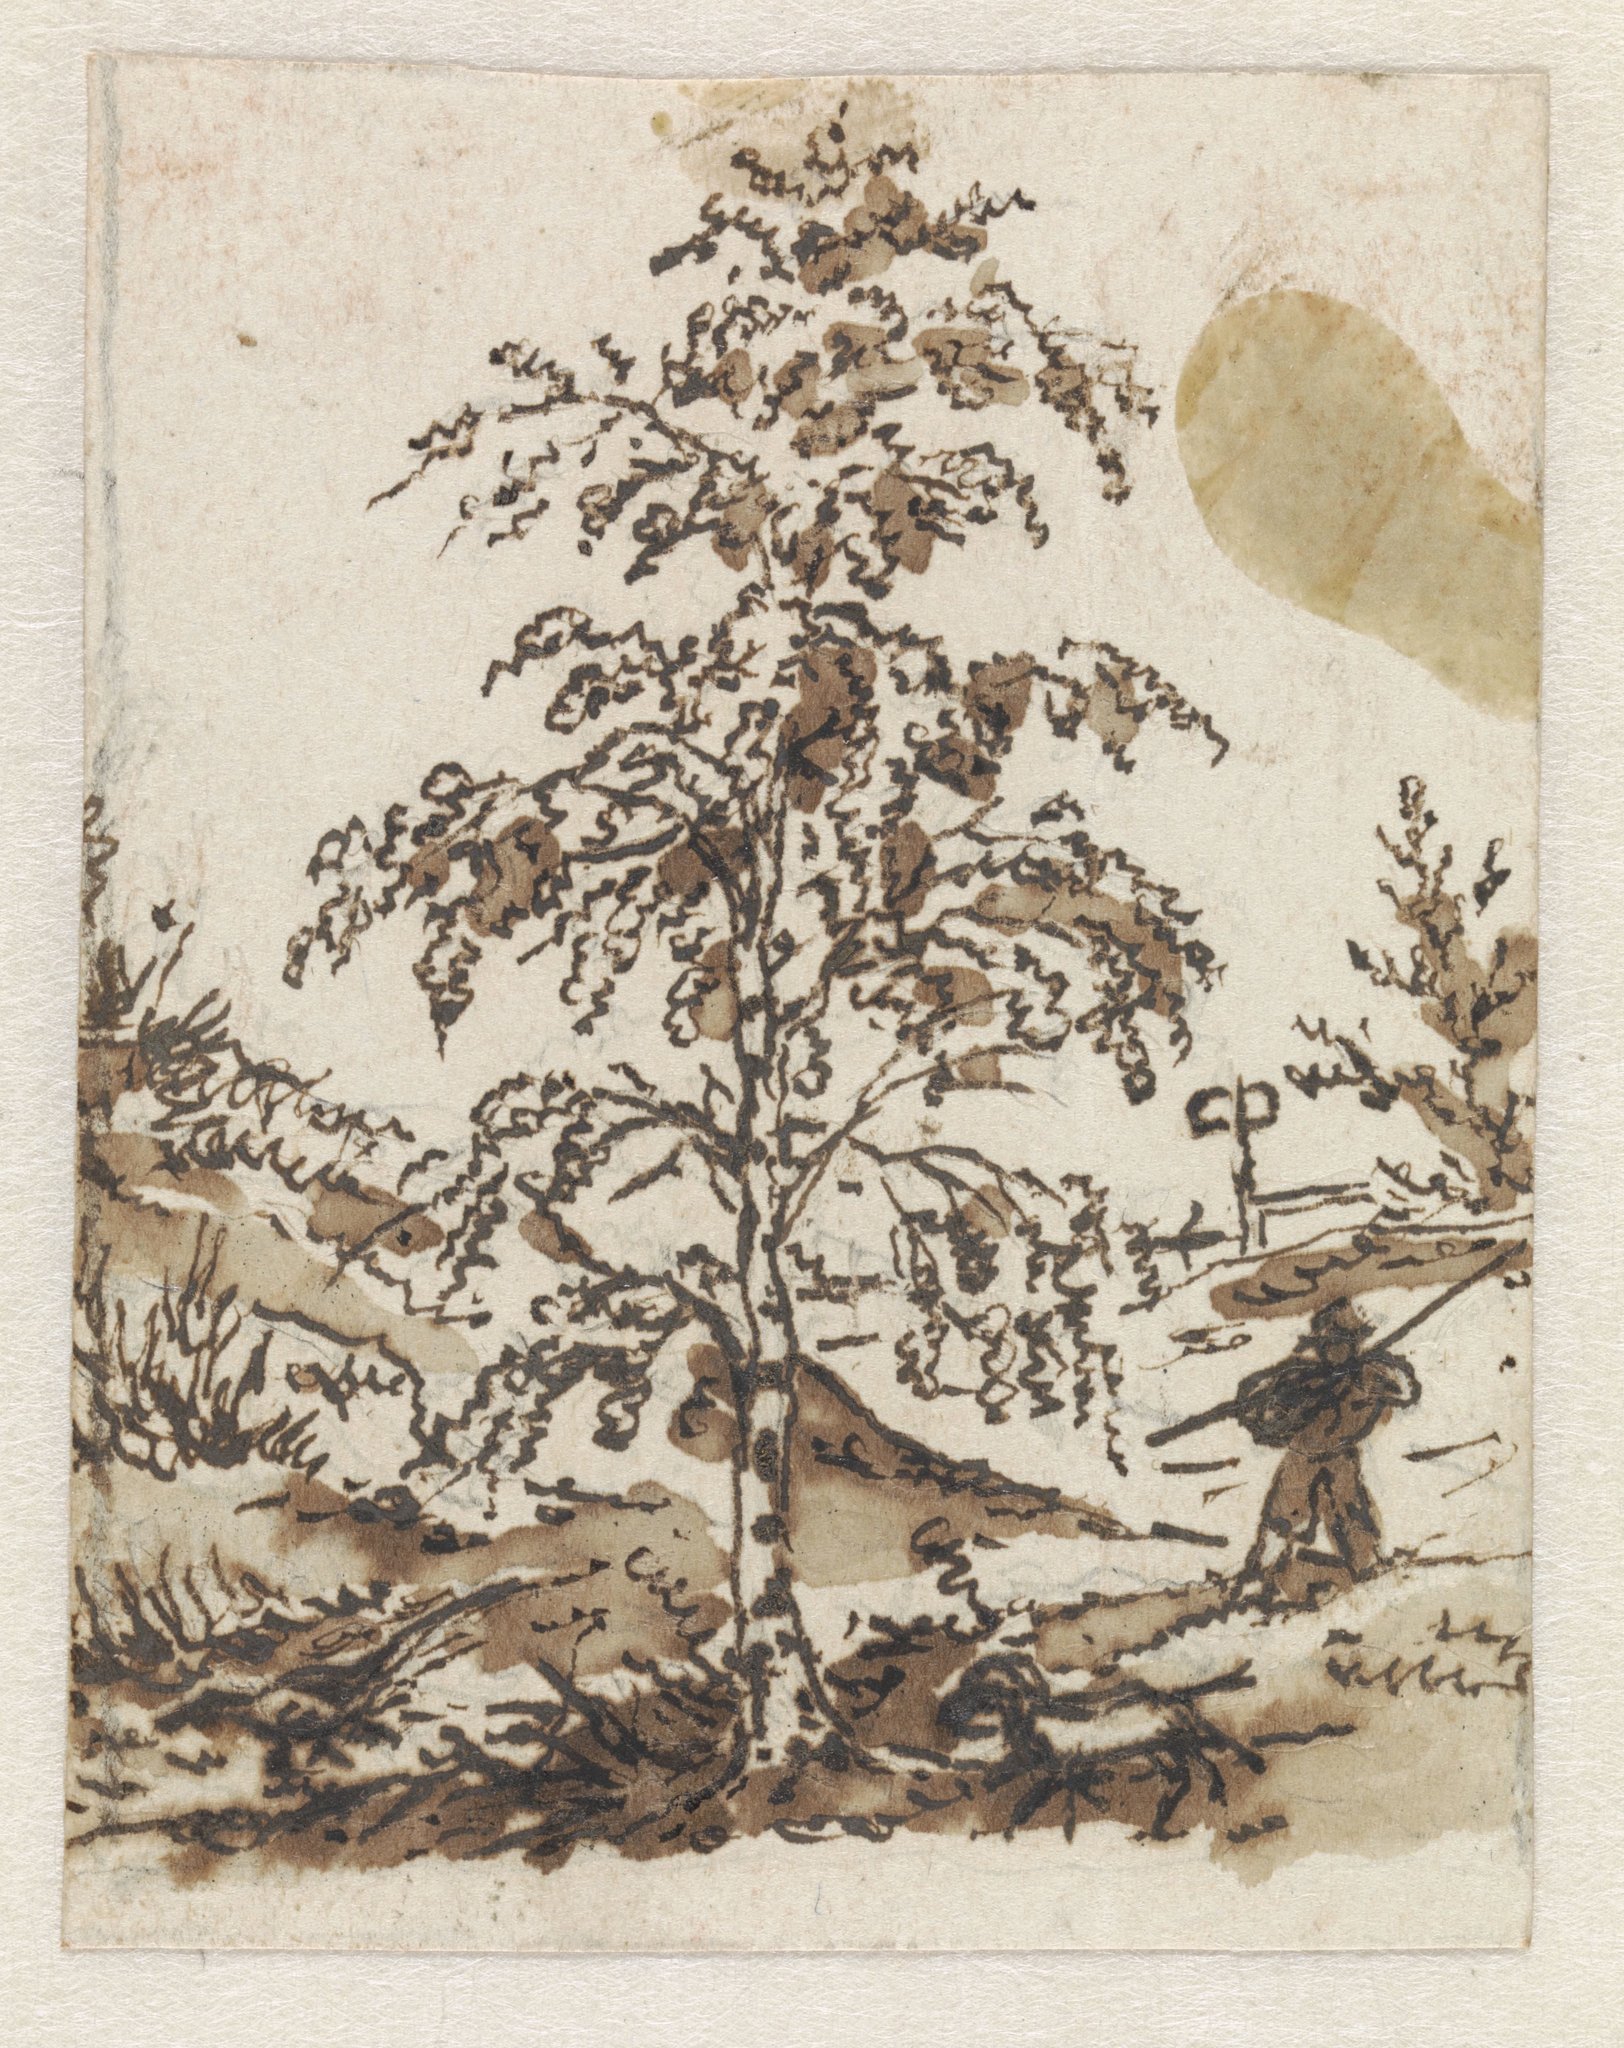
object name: drawing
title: Jager bij een berk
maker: gerardus emaus de micault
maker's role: draughtsman, print maker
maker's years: 1798-1863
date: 1799-1863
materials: ink, paper, pencil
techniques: brush, pen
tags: hunting, chase, trees: birch